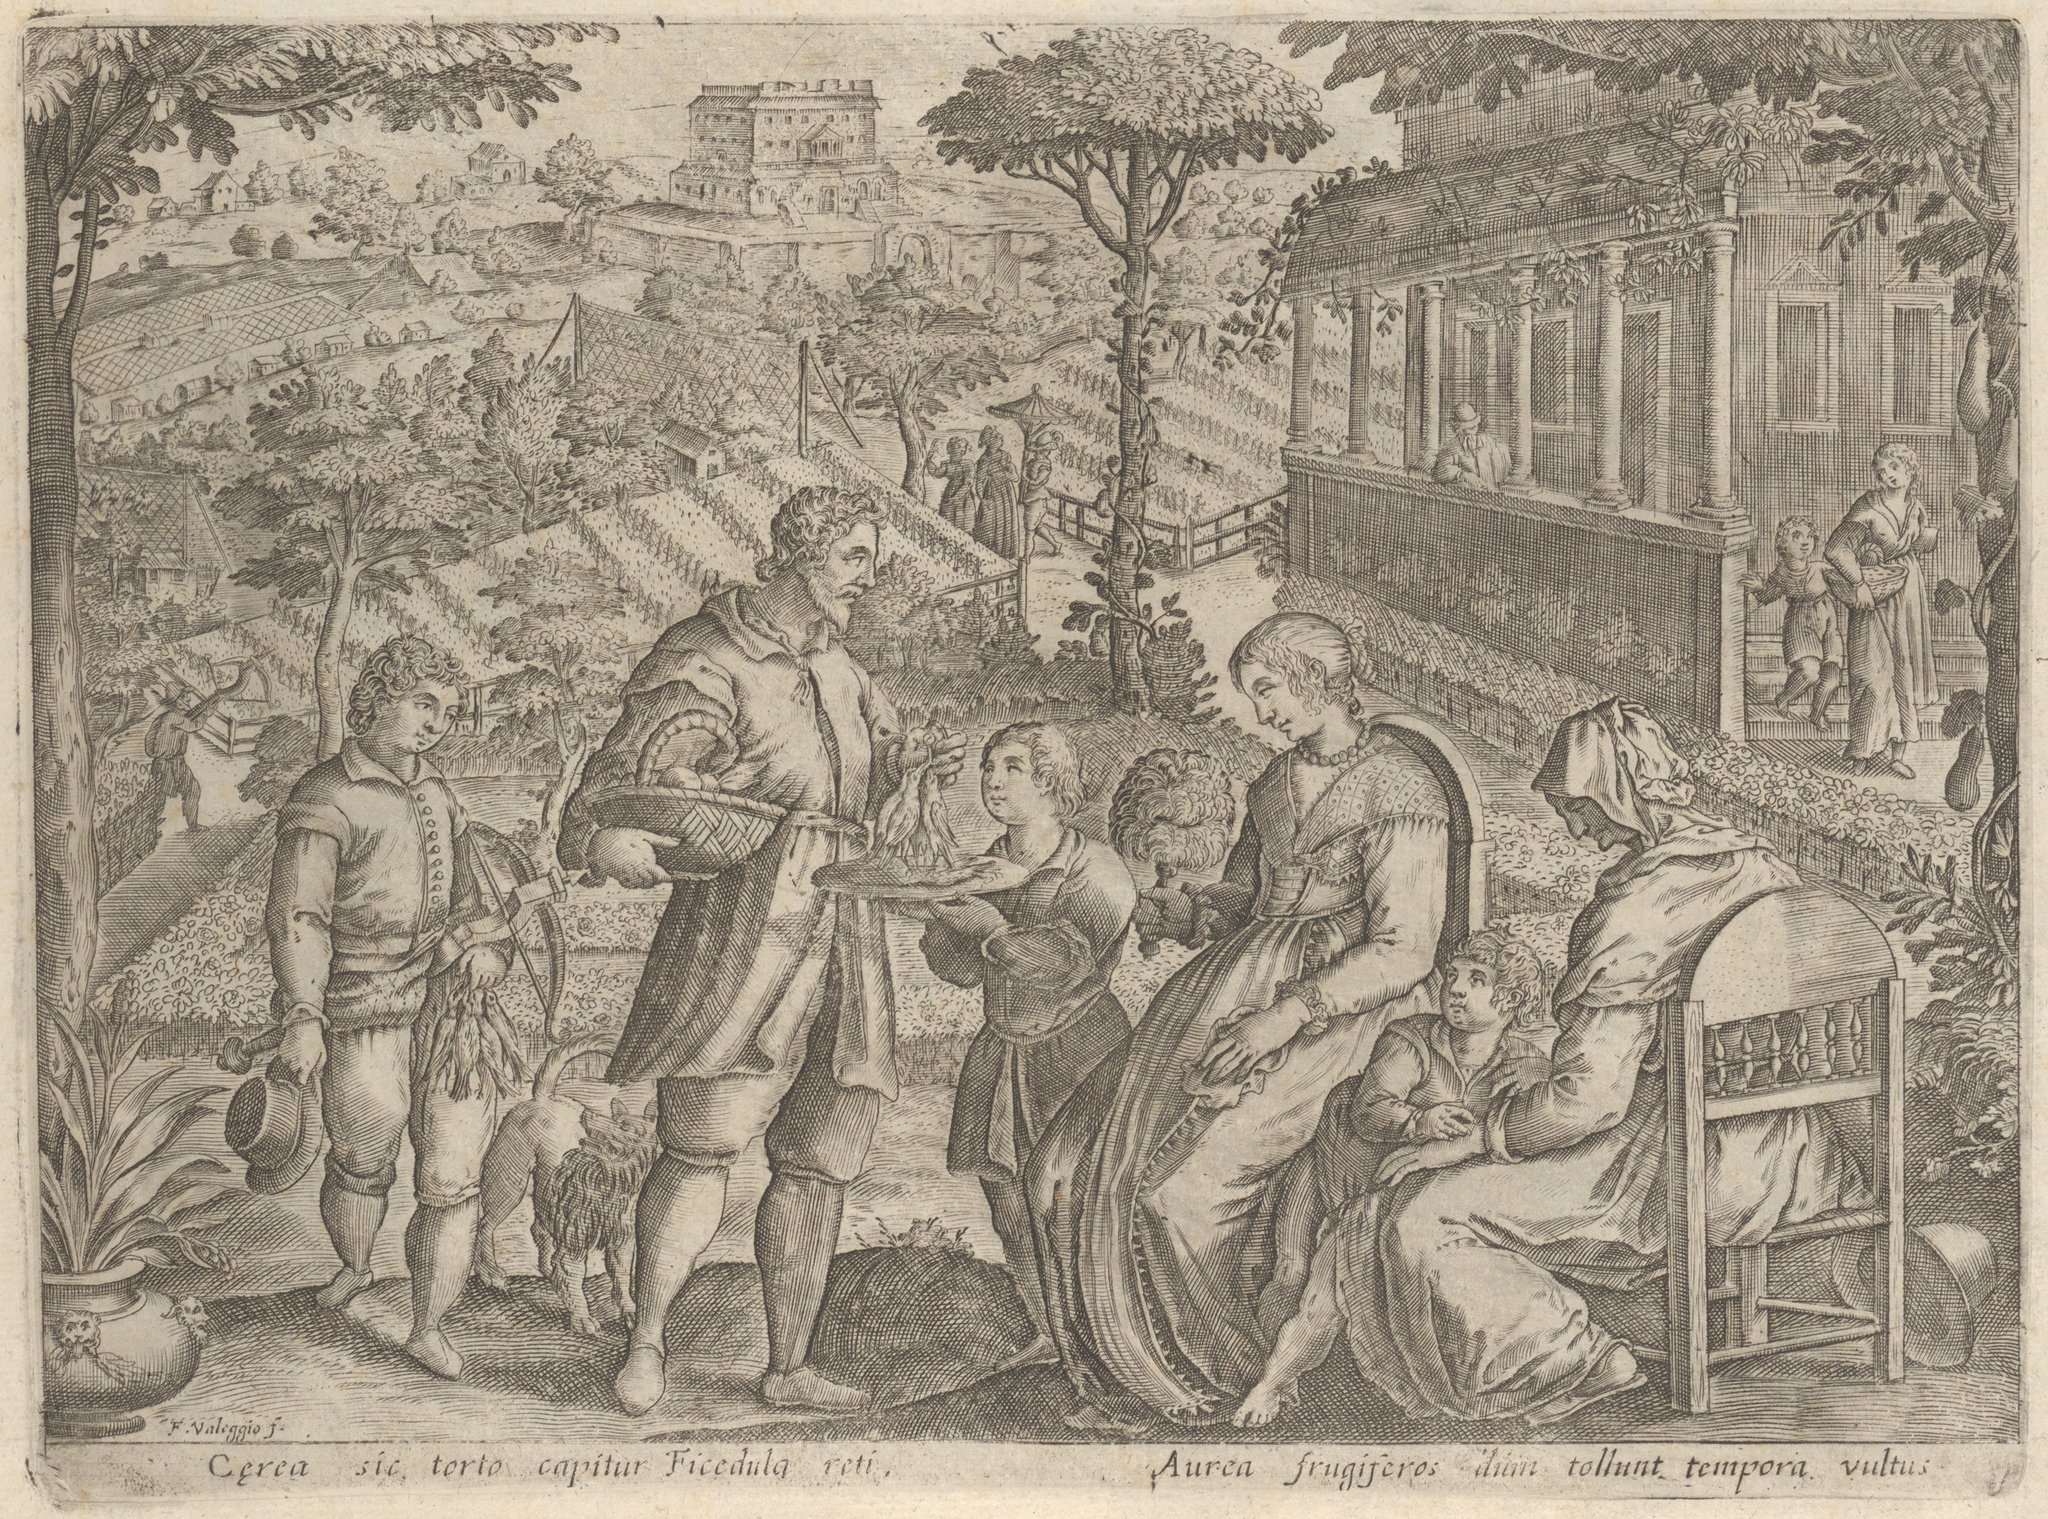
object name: book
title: Eleven bound prints of hunts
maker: francesco valesio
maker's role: illustrator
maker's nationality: italian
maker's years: 1598-1624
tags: buildings,children,men,women,trees